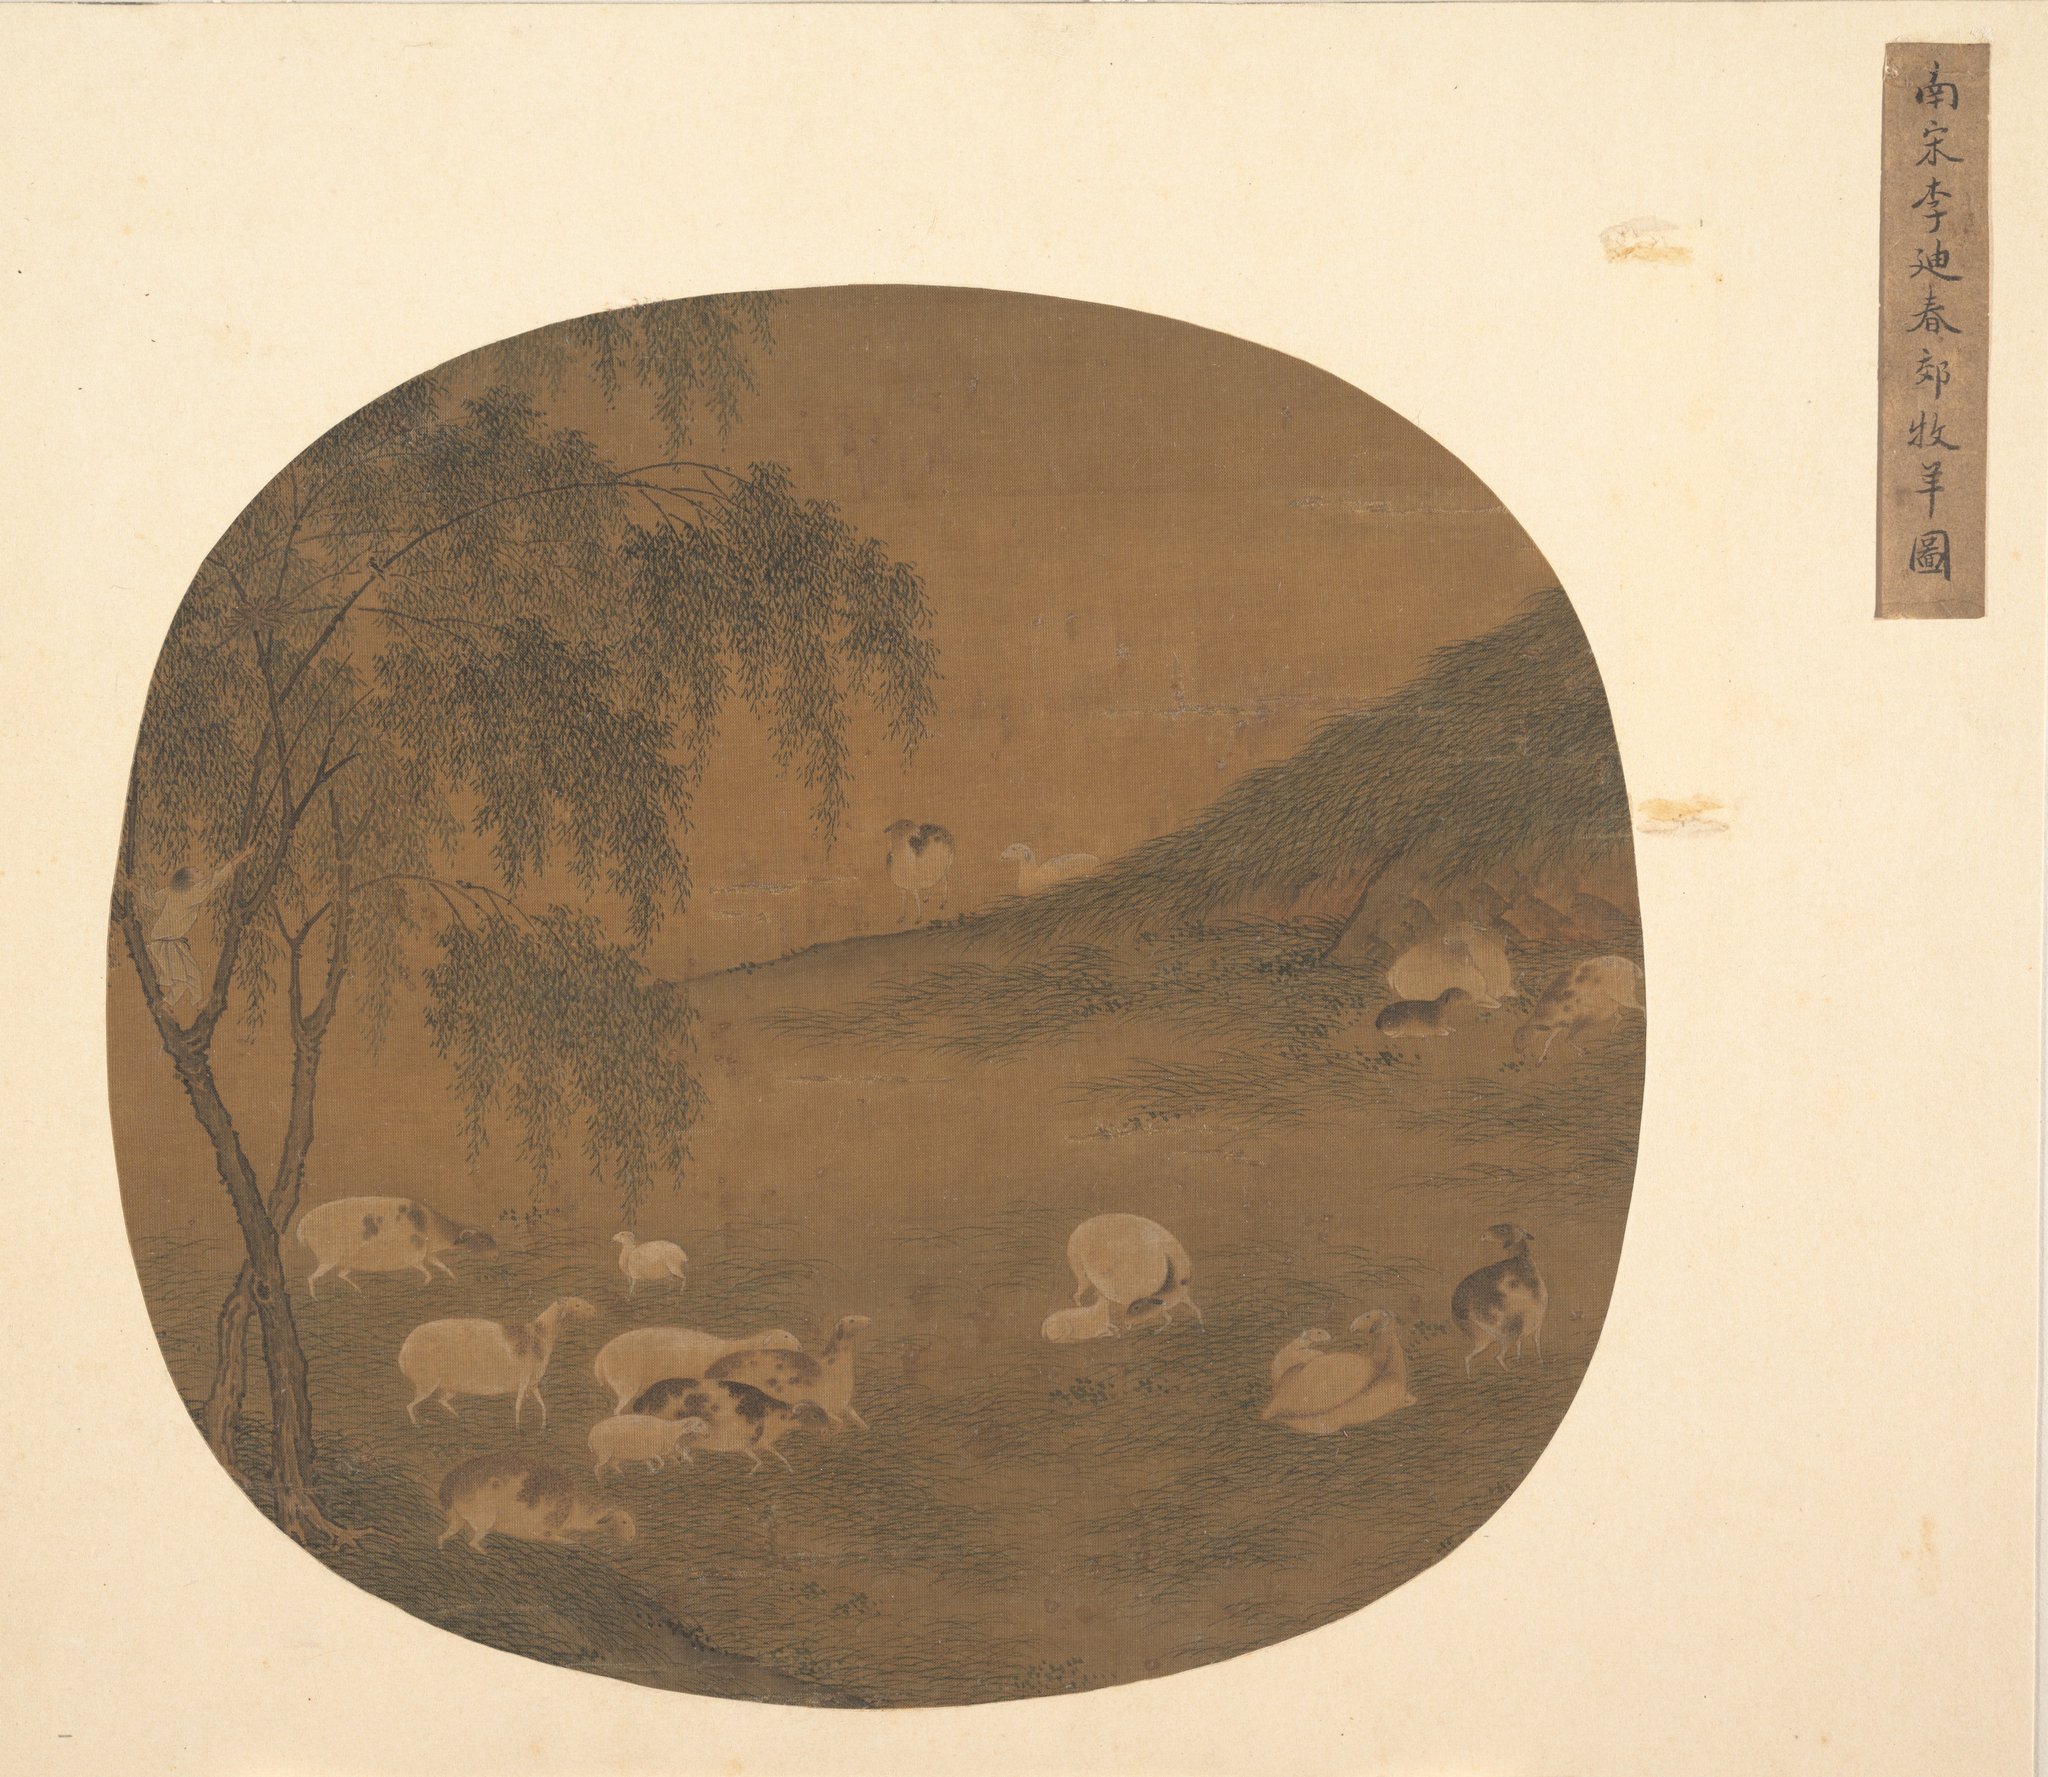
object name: fan mounted a an album leaf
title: Sheep and herd boy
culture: chinese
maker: unidentified artist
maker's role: artist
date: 1301-1400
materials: ink, silk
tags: boys,sheep